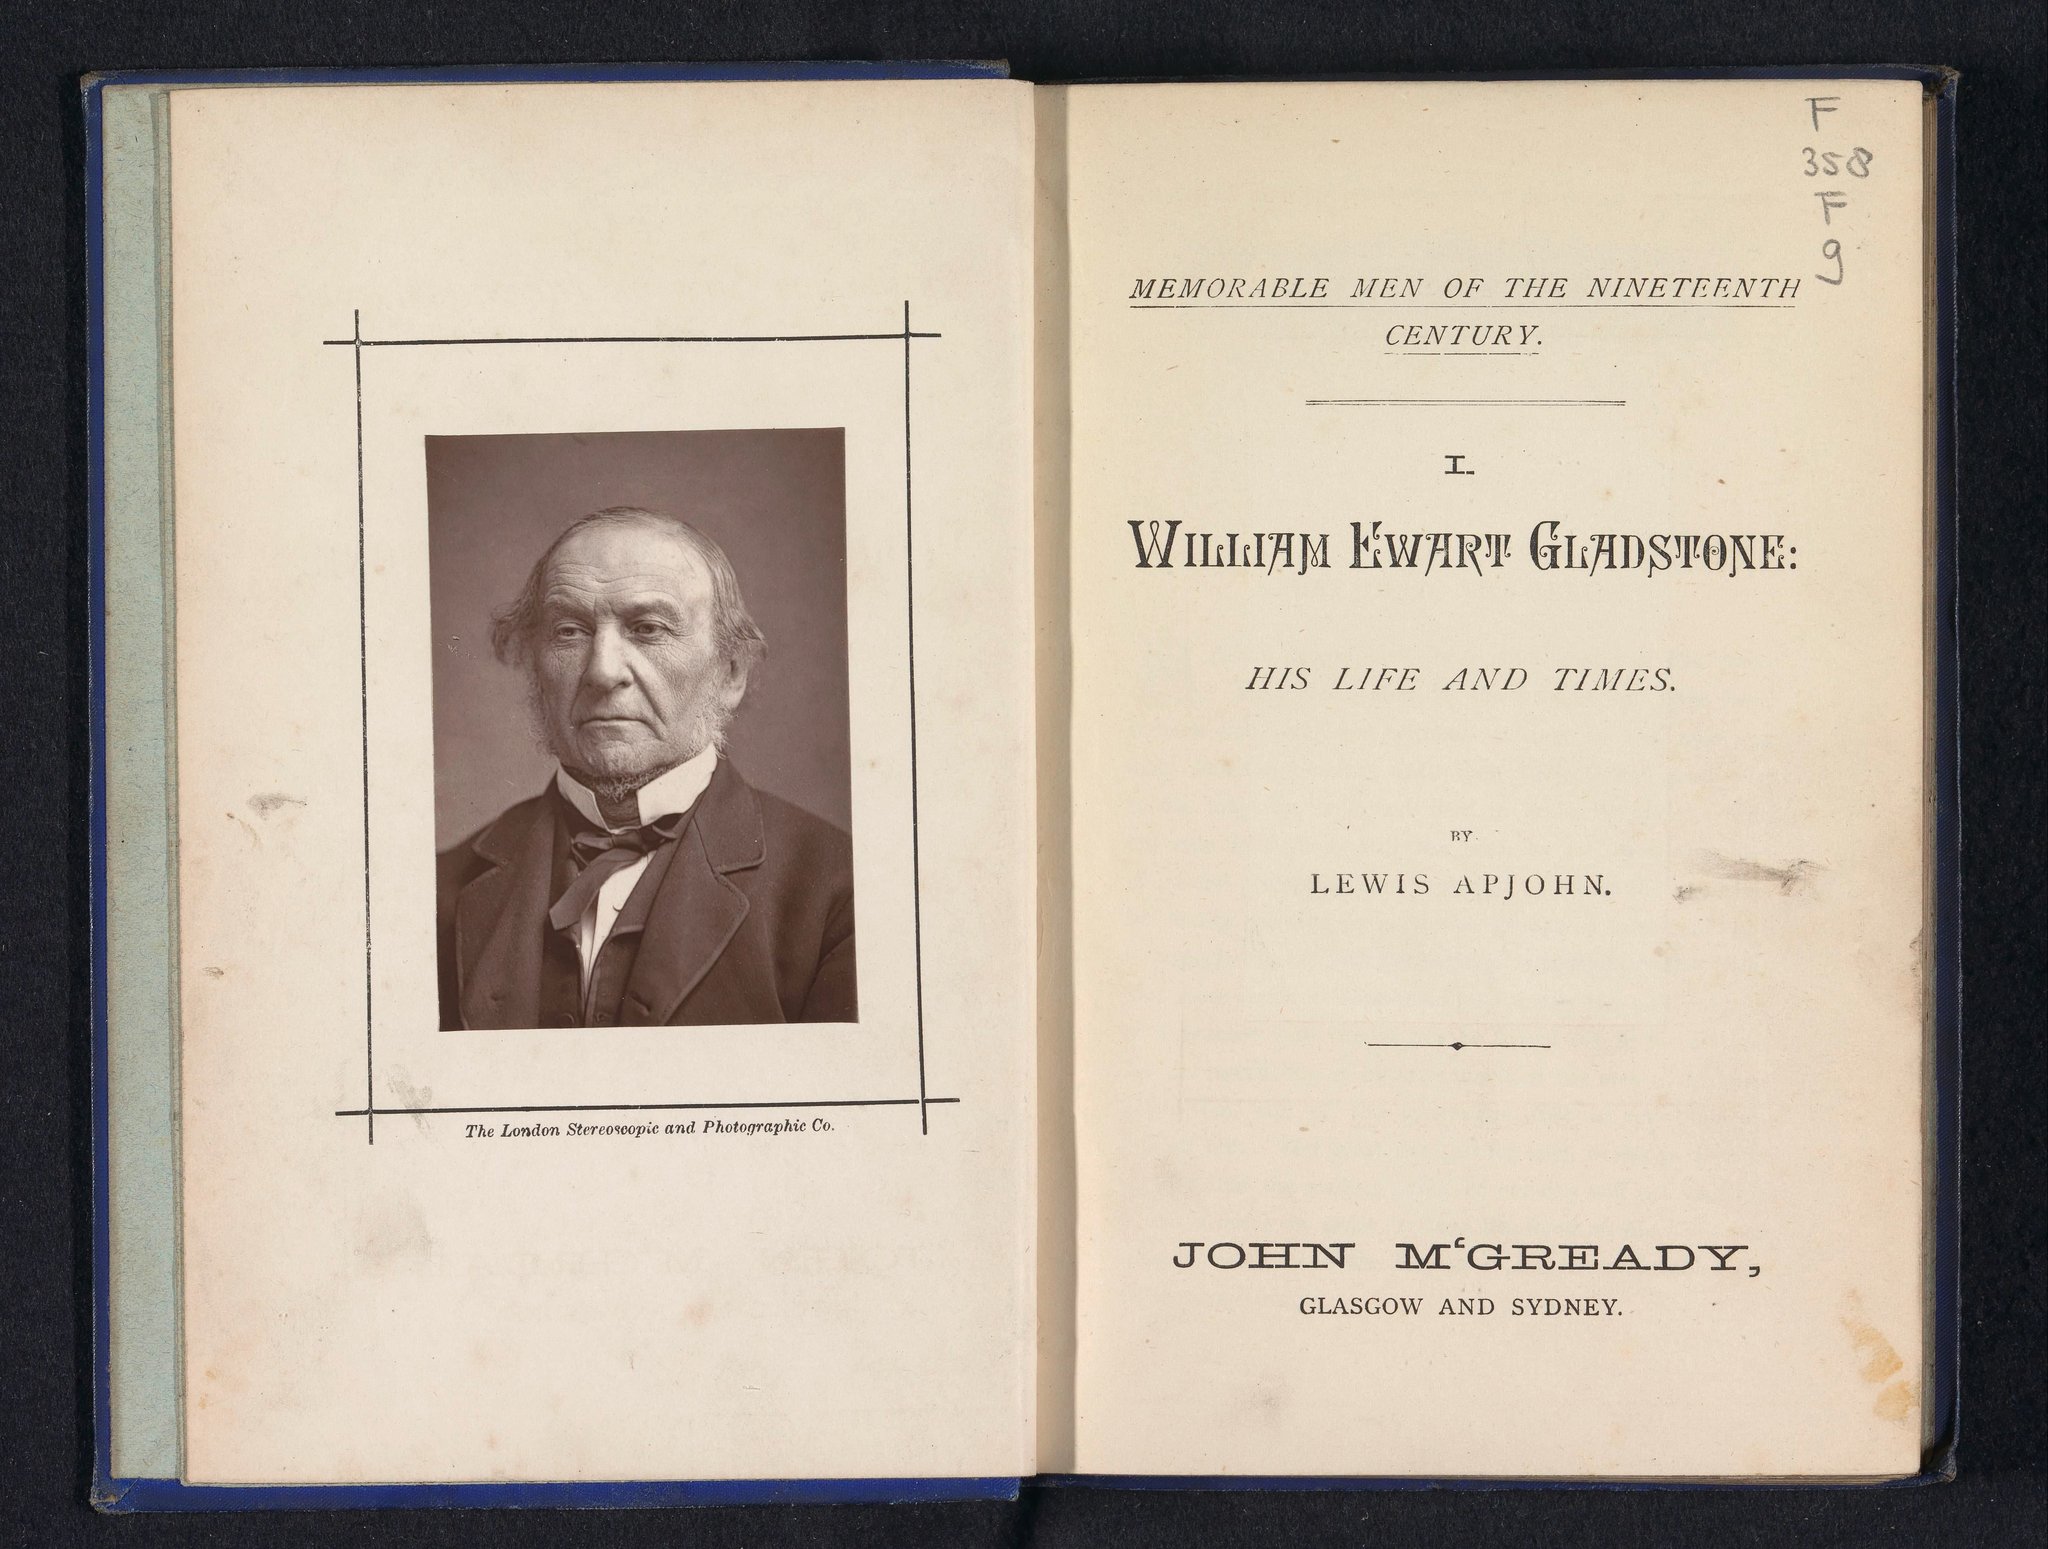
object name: book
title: William Ewart Gladstone his life and times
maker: lewis apjohn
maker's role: schrijver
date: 1888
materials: cardboard, linen, paper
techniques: woodburytype